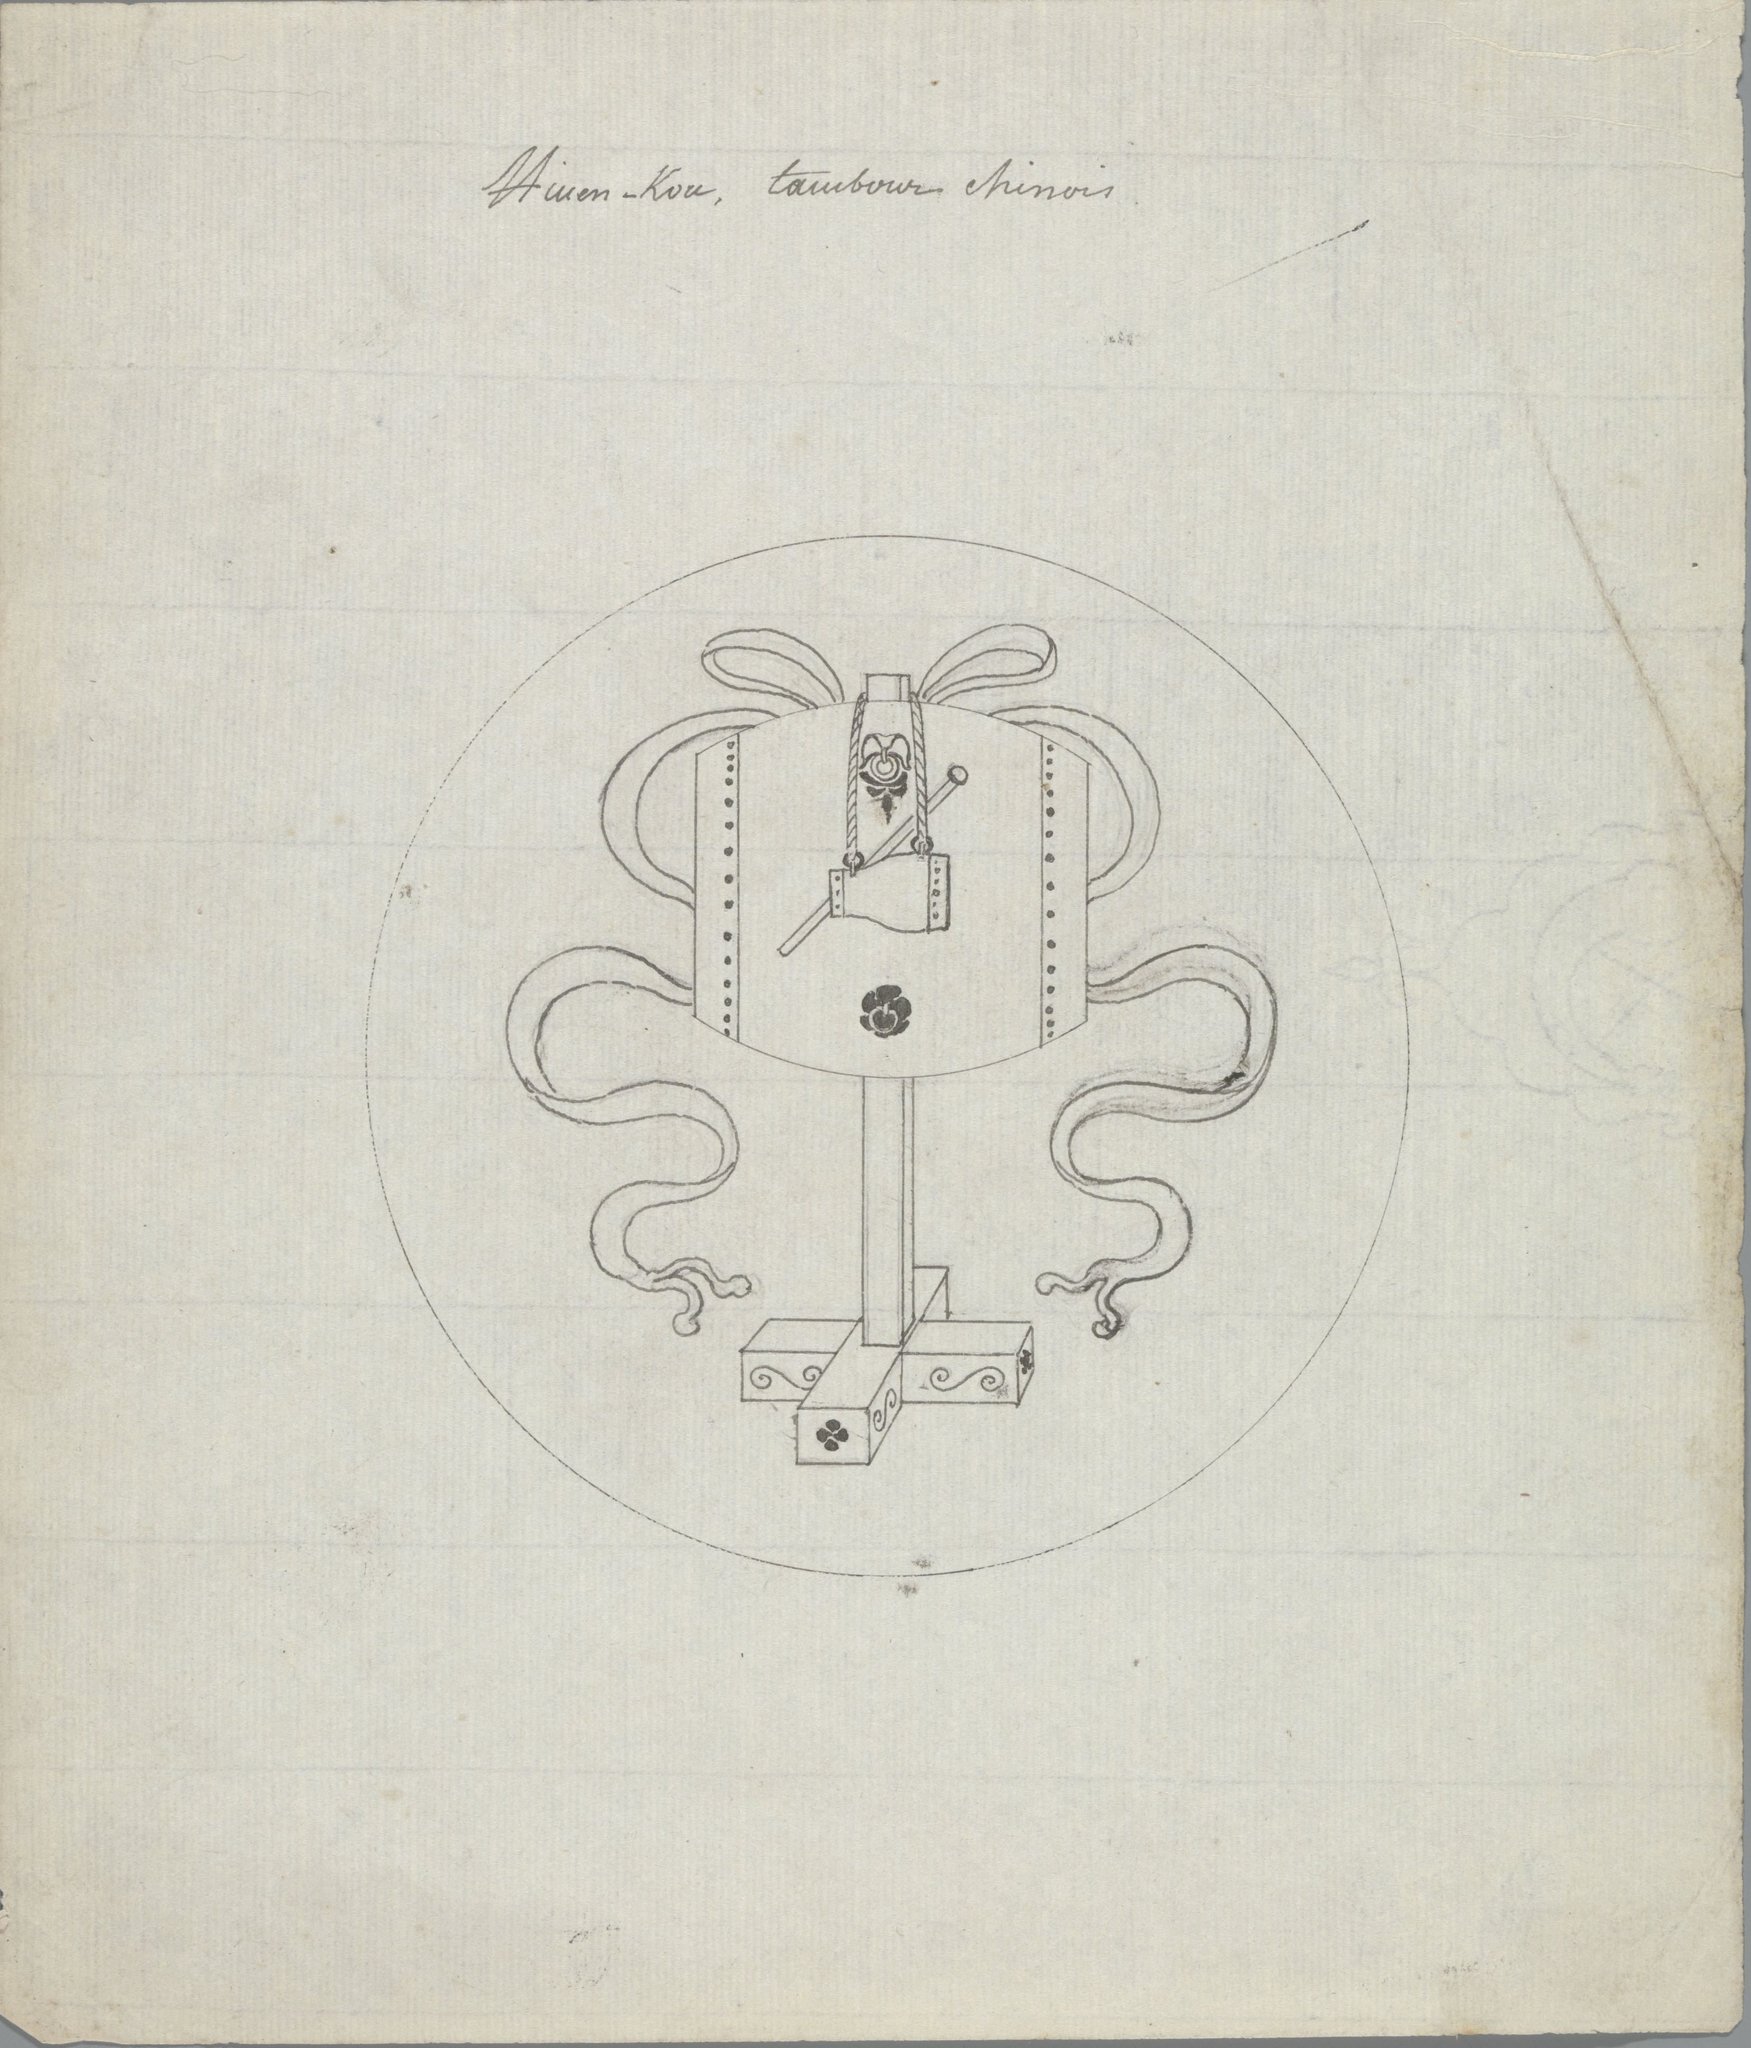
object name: design drawing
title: Ontwerp voor marqueterie van aan linten opgehangen muziekinstrument(en) in rond medaillon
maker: pierre félix van doren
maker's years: 1797-1856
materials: graphite, ink, paper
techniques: pen in black ink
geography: brussels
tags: trophy, i.e.: decorative arrangement of symbolic or typical objects ~ ornament, drum (musical instrument)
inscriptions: watermark, inscription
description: Een van 103 ontwerpen voor marqueterie van aan linten opgehangen muziekinstrumenten in ronde medaillons, bestemd voor de set stoelen gemaakt door Van Doren voor de grote zaal van het Paleis van de Prins van Oranje in Brussel in 1828.